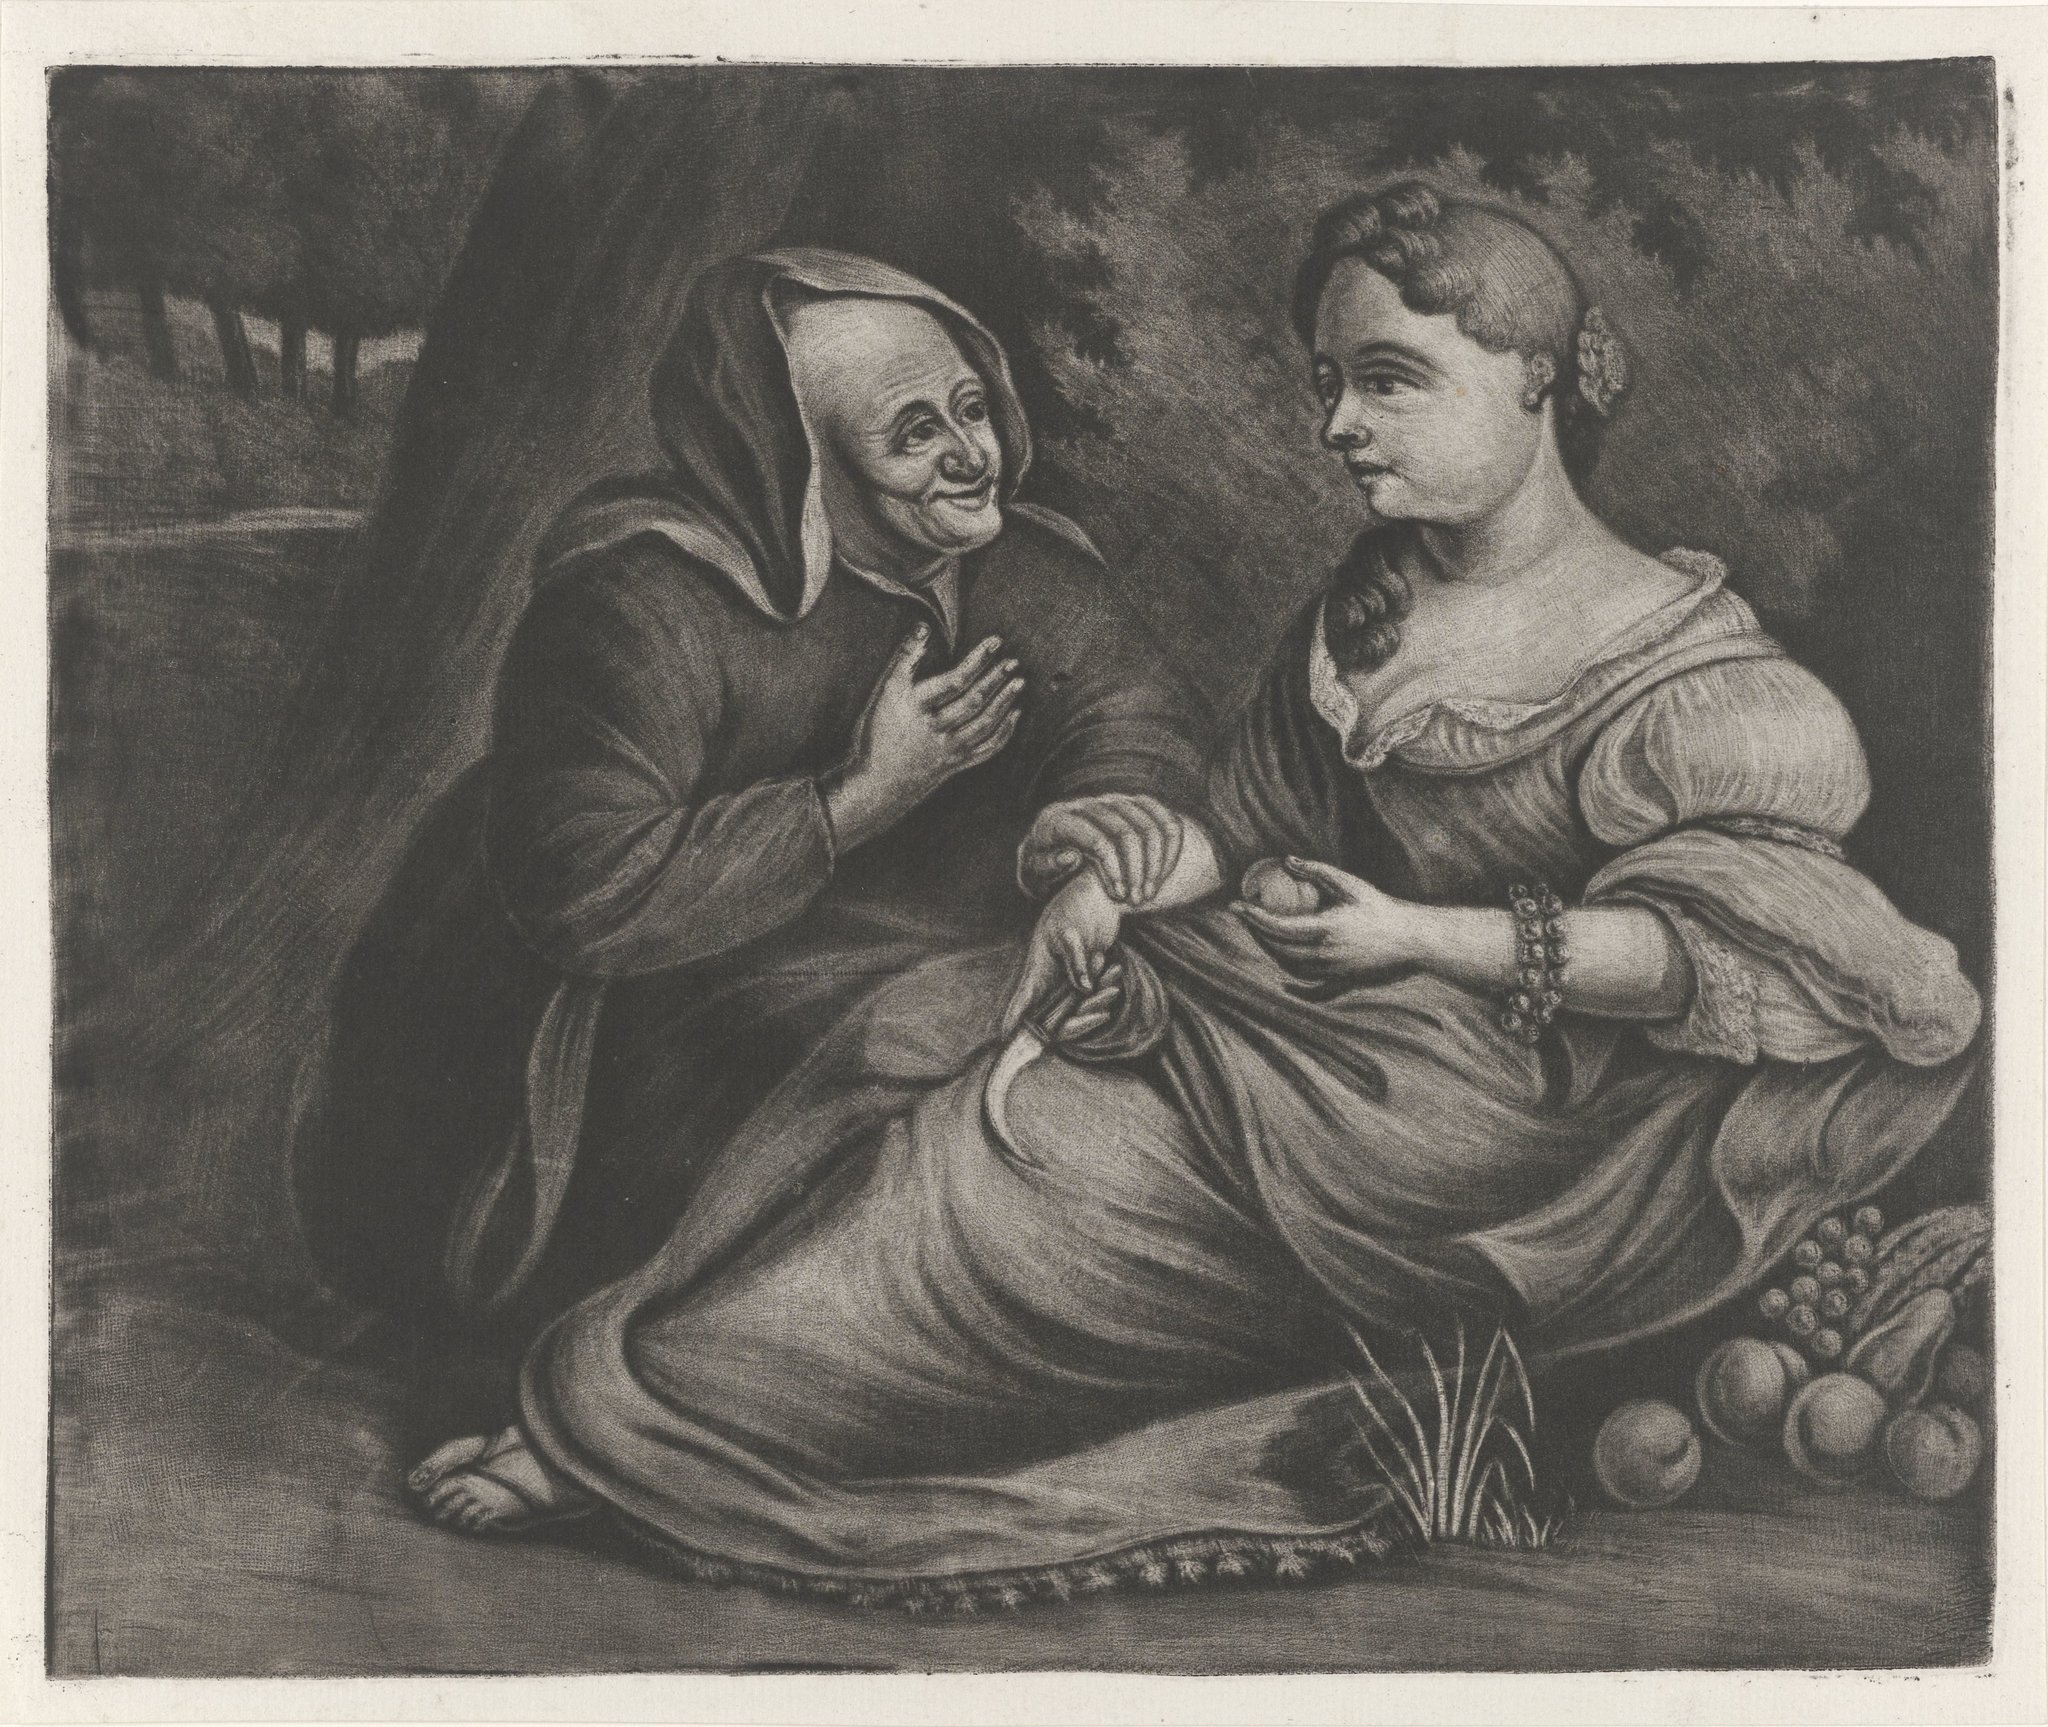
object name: print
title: Vertumnus en Pomona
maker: jacob hoolaart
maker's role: print maker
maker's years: 1713-1789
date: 1723-1789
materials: paper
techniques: mezzotint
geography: dordrecht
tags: vertumnus and pomona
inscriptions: collector's mark: Lugt 2228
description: Vertumnus, de Italiaanse god en beschermer van tuinen en boomgaarden, en Pomona zitten voor het struikgewas. Vertumnus, in de gedaante van een oude vrouw, verleidt Pomona.